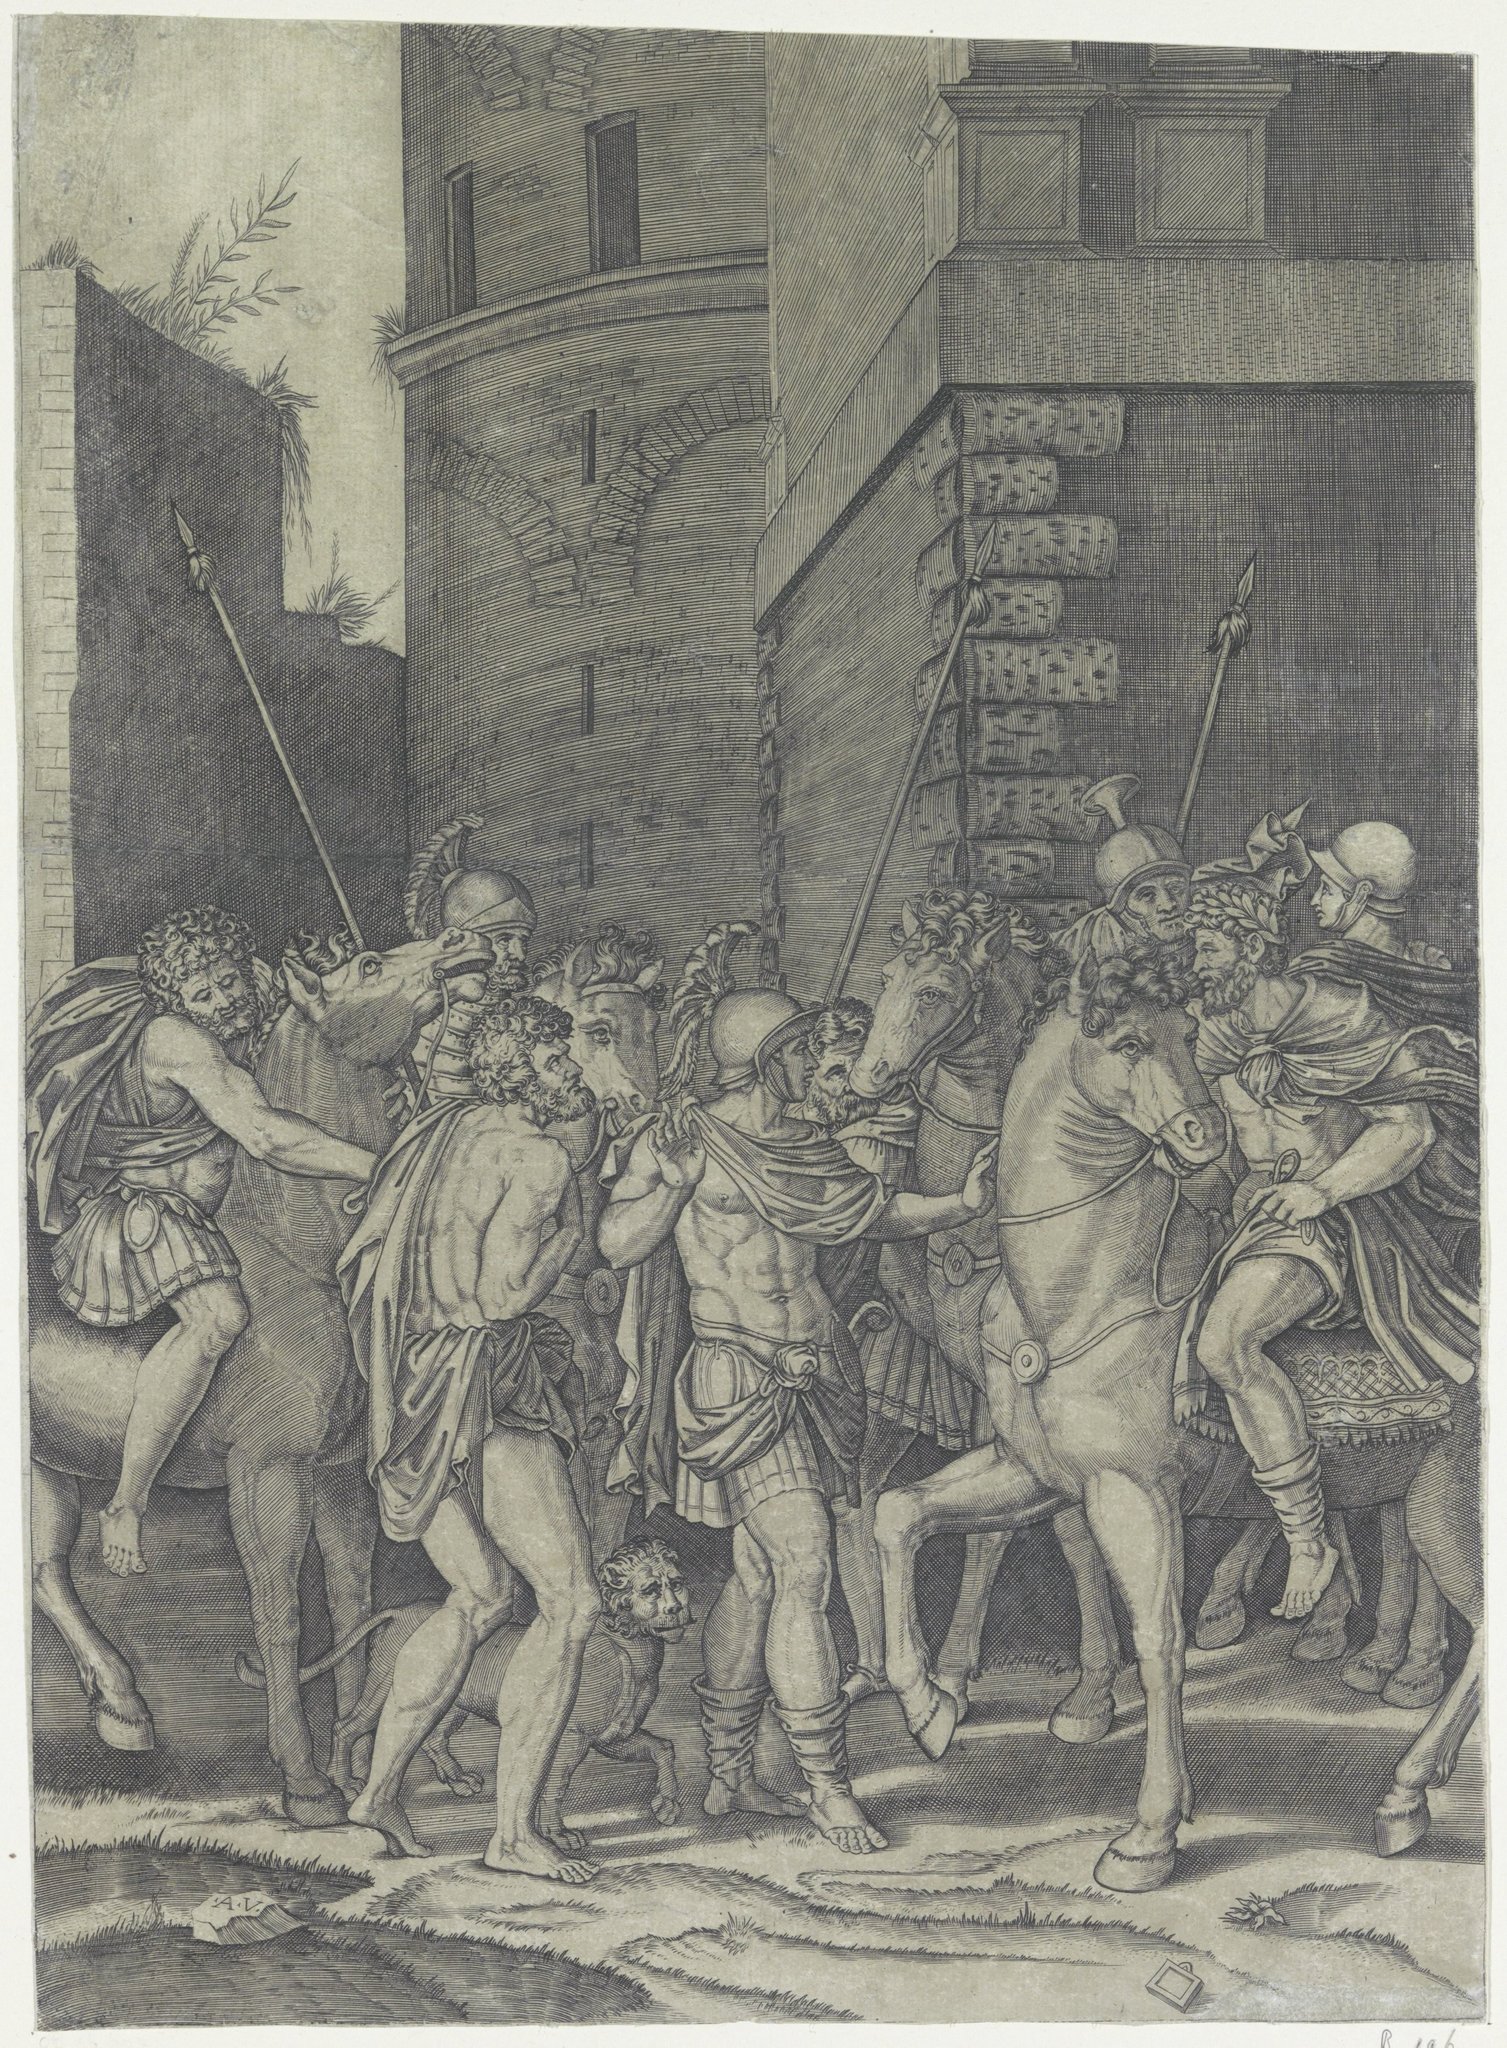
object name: print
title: Hadrianus ontmoet Androclus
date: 1500-1536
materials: paper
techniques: engraving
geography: italy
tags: (story of) androclus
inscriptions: collector's mark: Lugt 240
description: De Romeinse keizer Hadrianus, te paard, ontmoet Androclus die links staat te midden van Romeinse soldaten. Naast Androclus de leeuw uit wiens poot hij een doorn verwijderde.